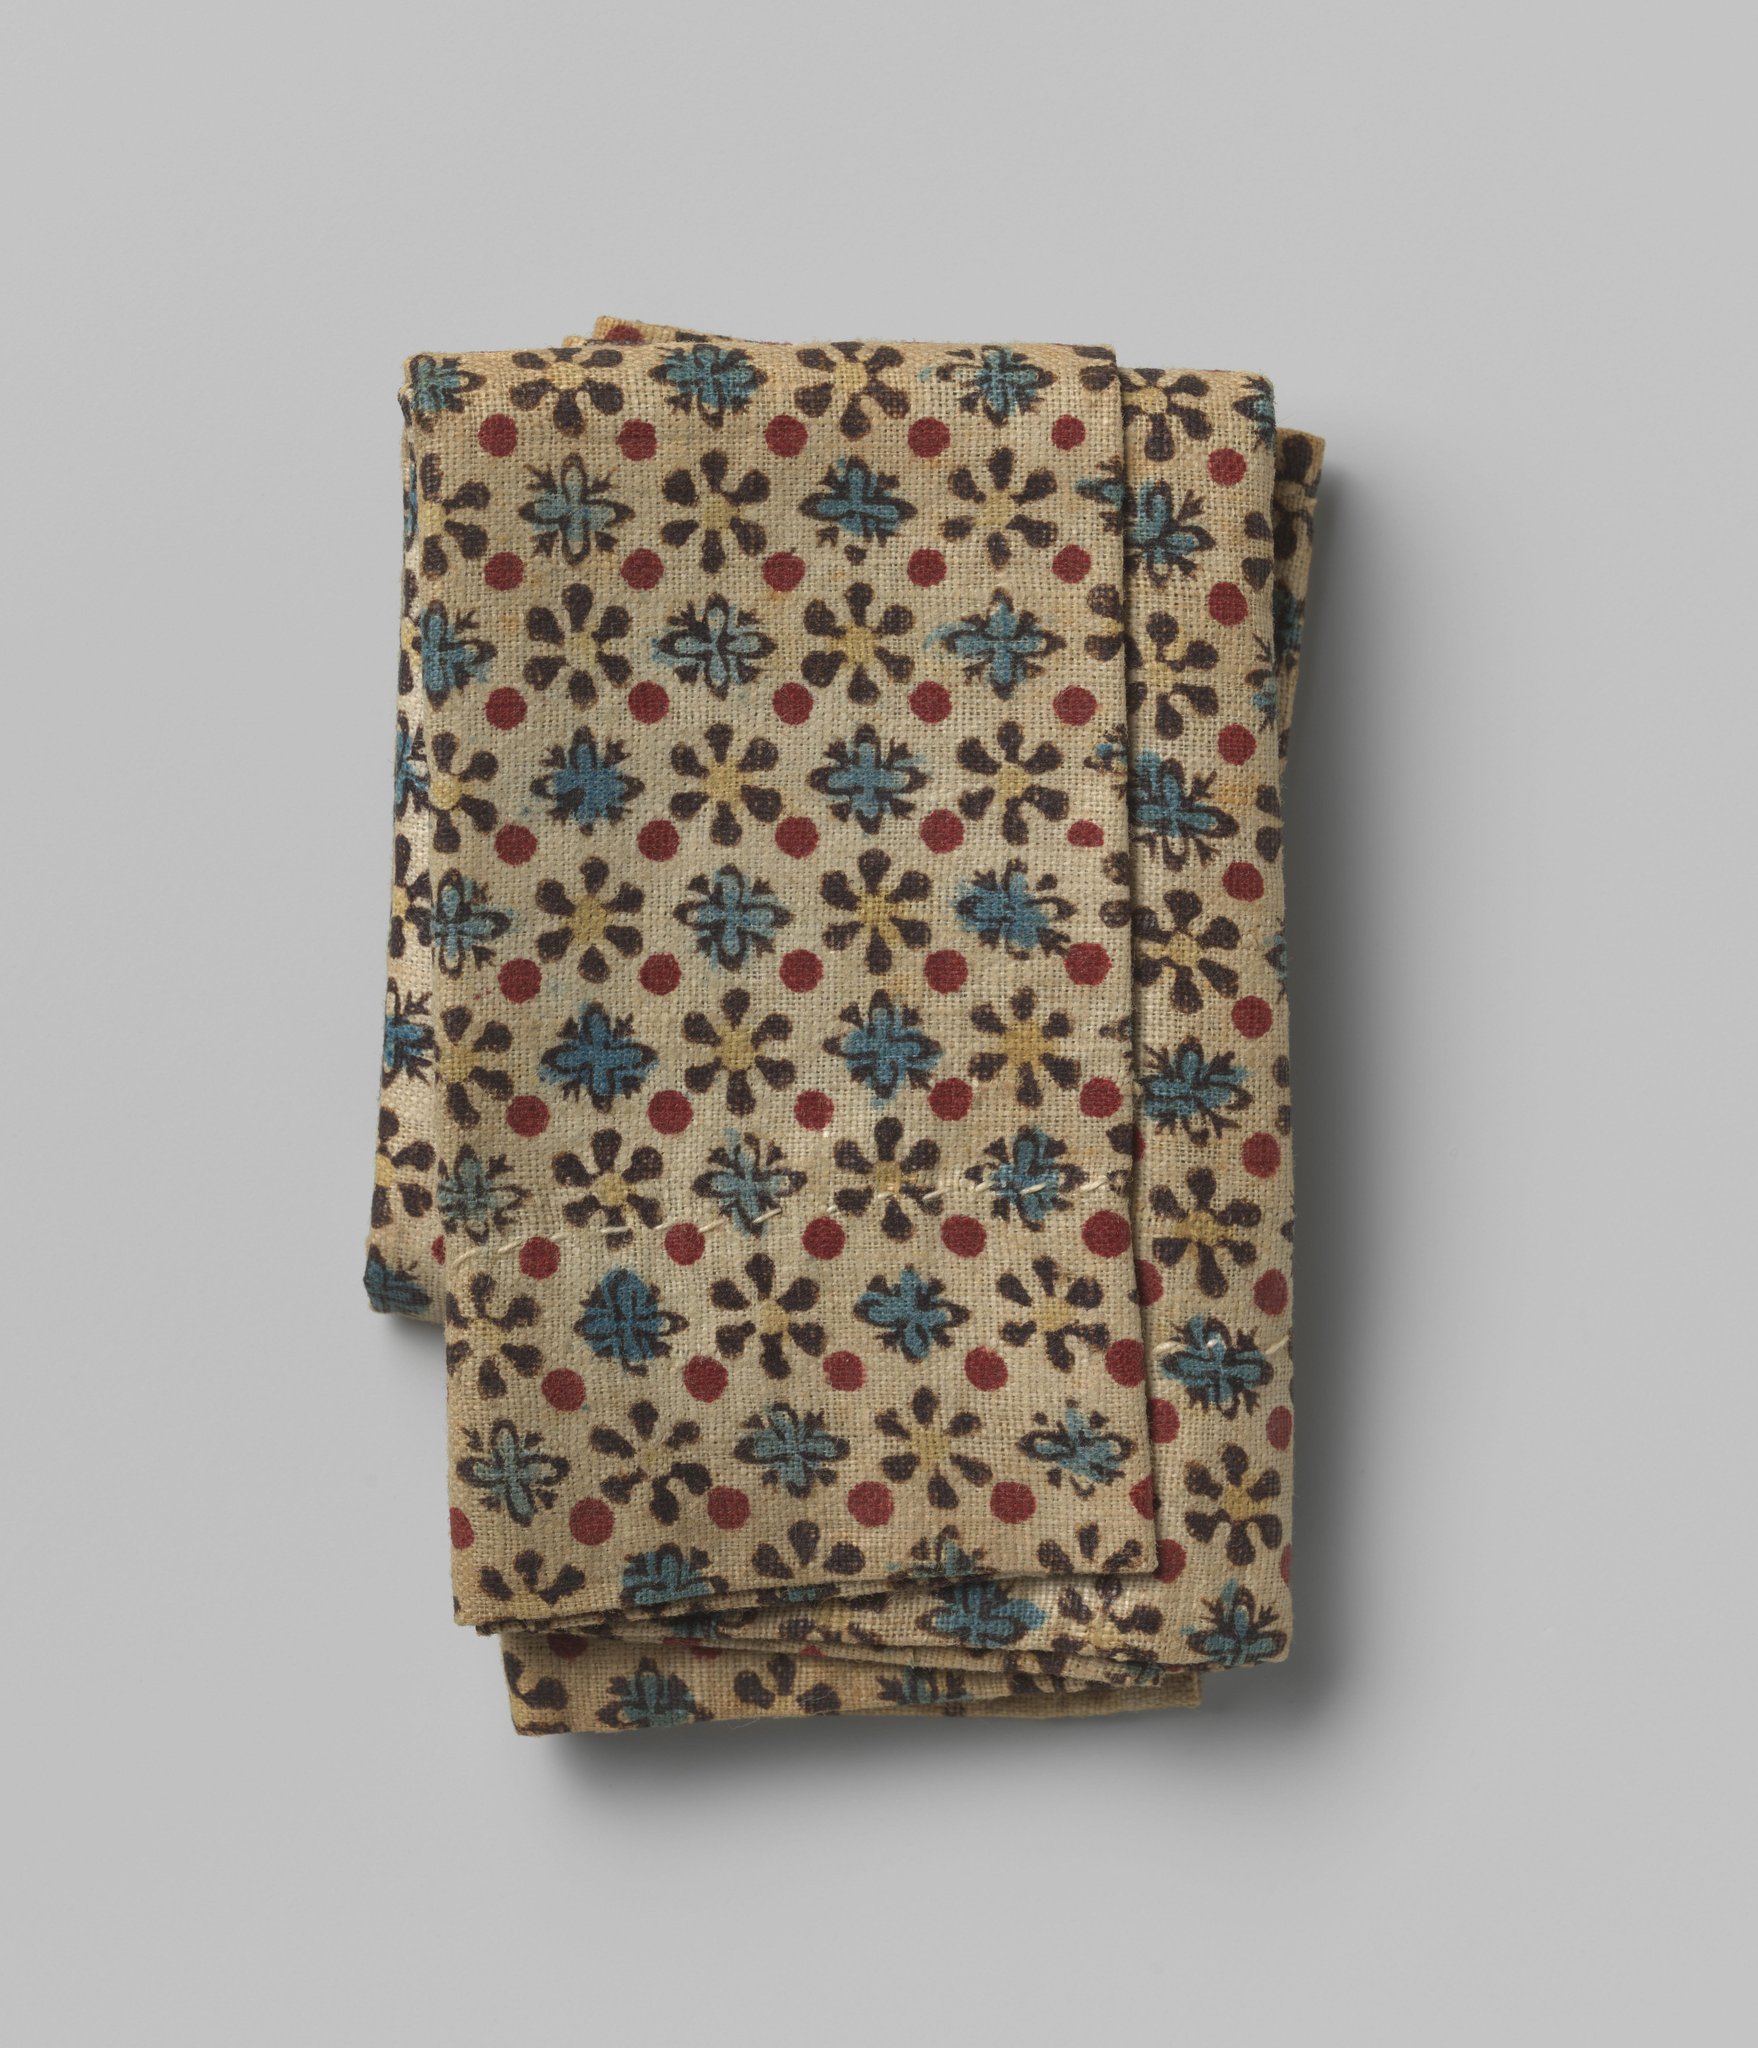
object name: poppengoed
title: Rechthoekige doek van geweven geglansd textiel met gedrukt patroon van rode stippen, bloemen en blauwe kruisvormen op wit fond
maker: Anonymous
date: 1790-1810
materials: textile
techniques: printing, weave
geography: europe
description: Onderdeel van set poppengoed met mand, drie doeken, paar kousen en po.